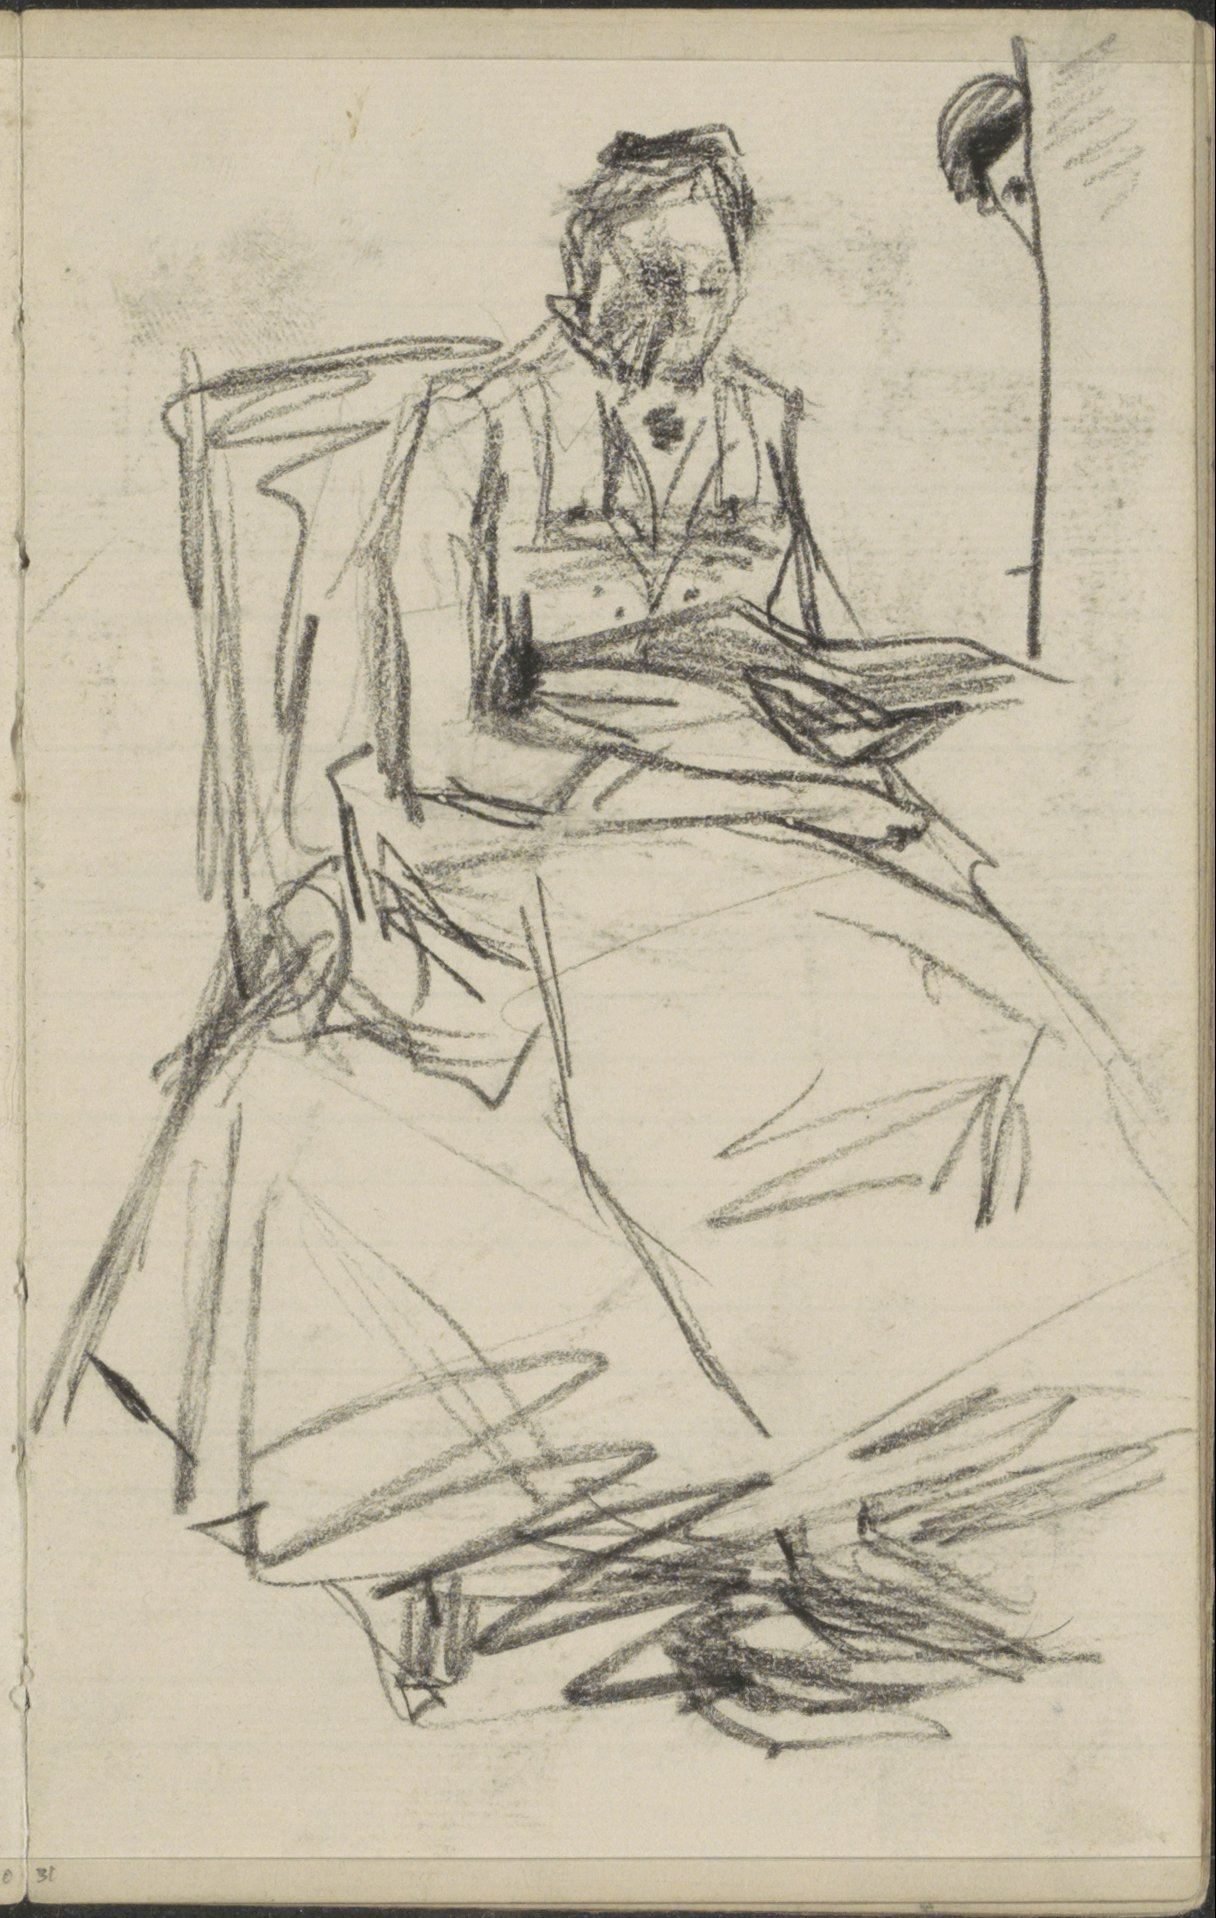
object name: sketchbook leaf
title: Lezende vrouw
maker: marius bauer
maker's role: draughtsman, print maker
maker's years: 1867-1932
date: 1881-1885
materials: chalk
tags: sitting figure, adult woman, reading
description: De vrouw zit in een stoel met een boek. Pagina 31 uit een schetsboek met 26 bladen.